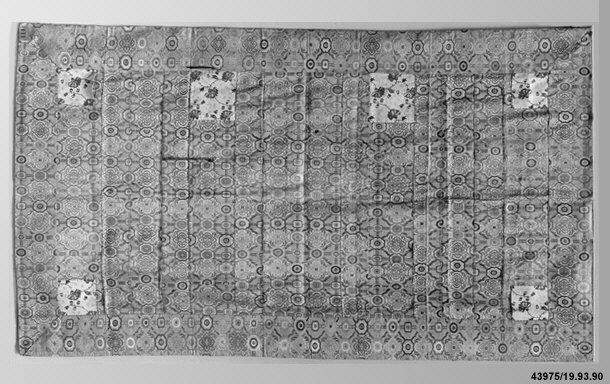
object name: robe, priest's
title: Priest's Robe (Shichijō)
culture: japanese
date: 1716-1736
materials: silk